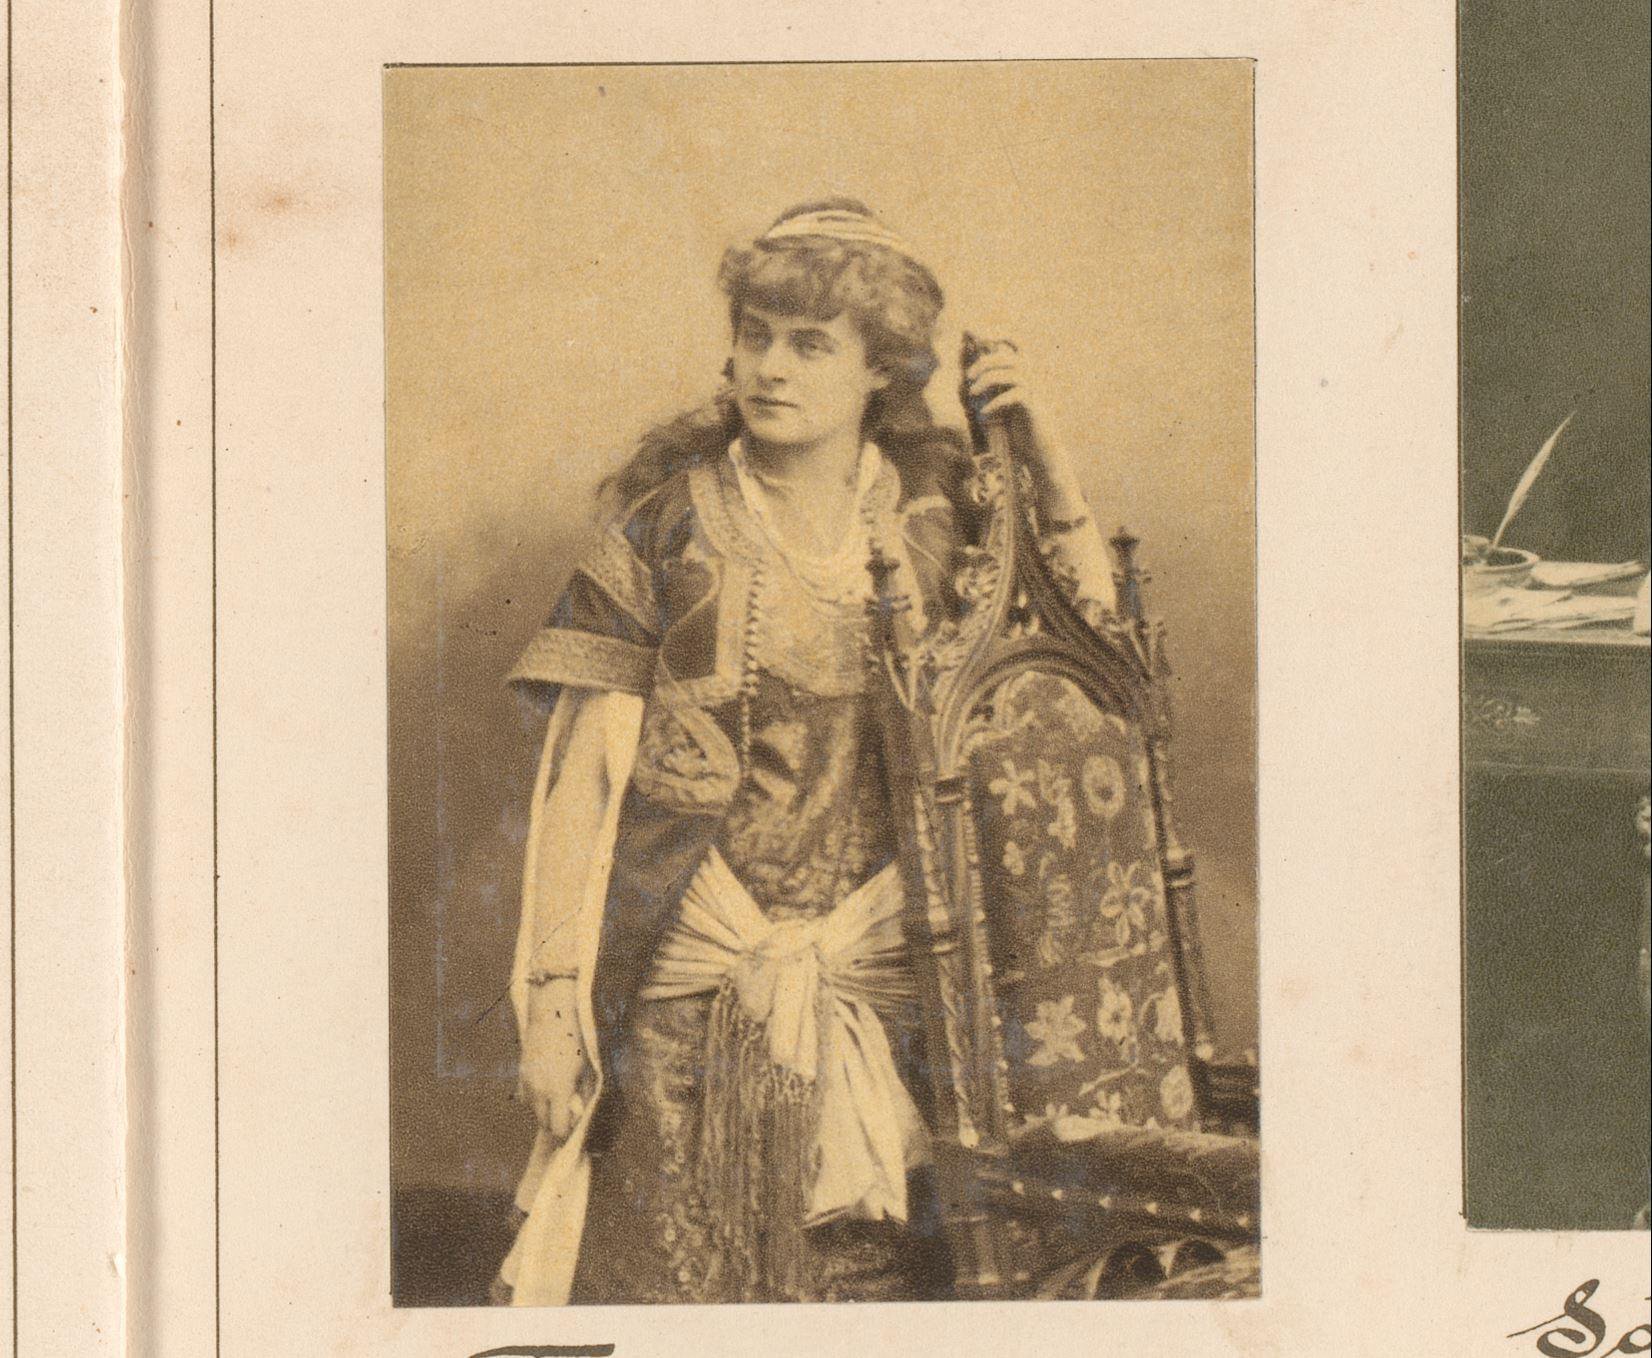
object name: photograph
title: Feyghine (en 1881)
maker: Anonymous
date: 1881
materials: paper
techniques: rotogravure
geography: france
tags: portrait of actor, actress, france